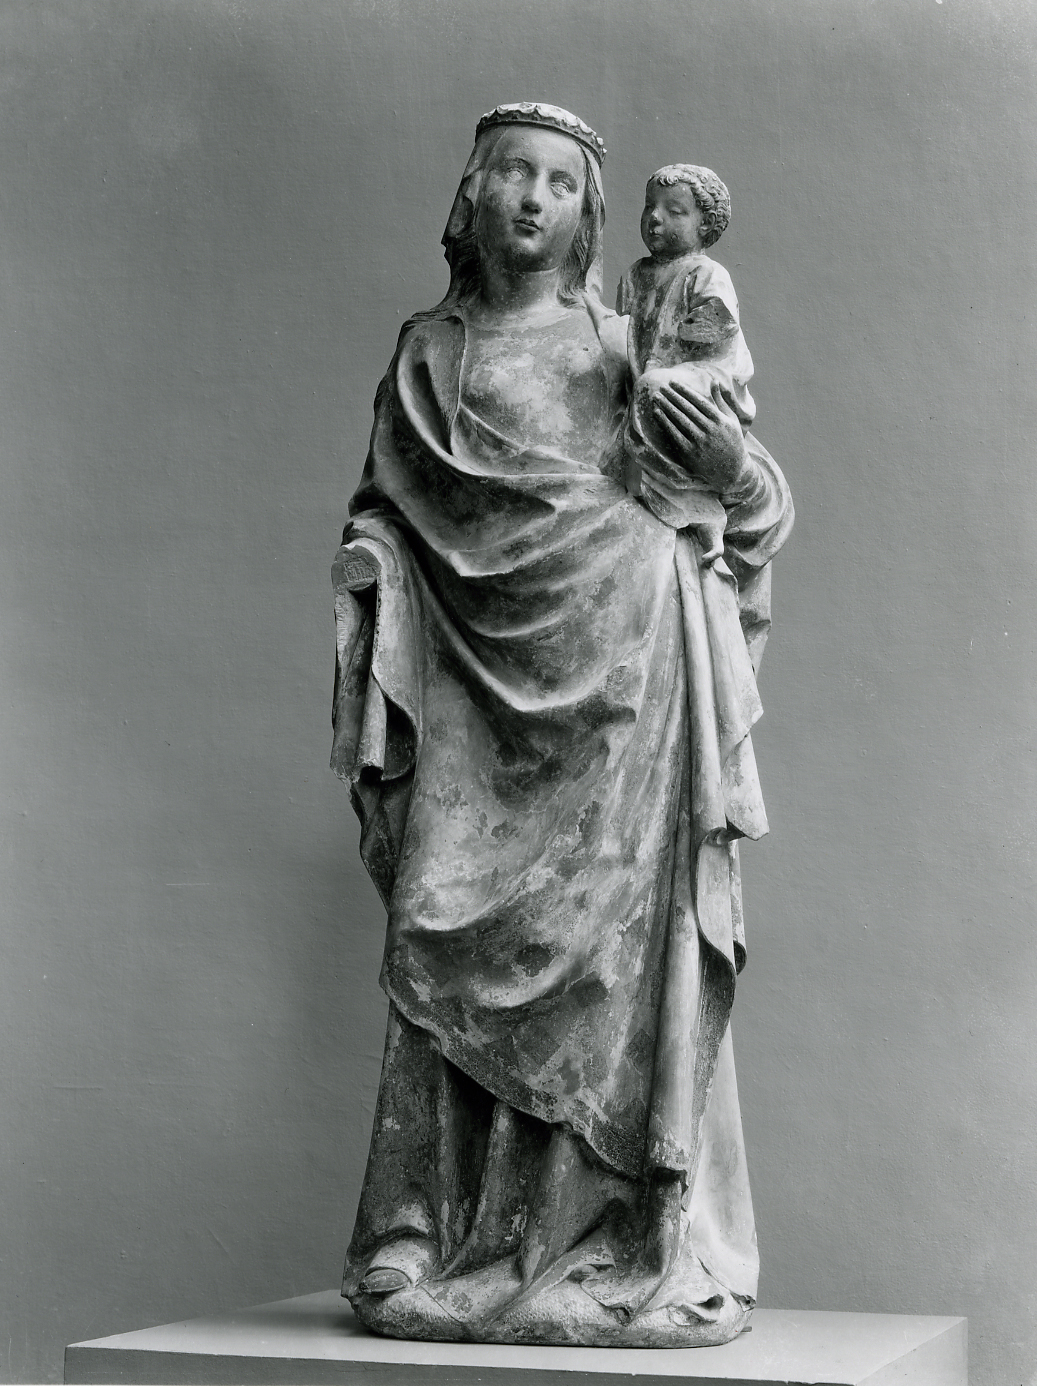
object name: statue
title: Virgin and Child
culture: french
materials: stone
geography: france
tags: madonna and child